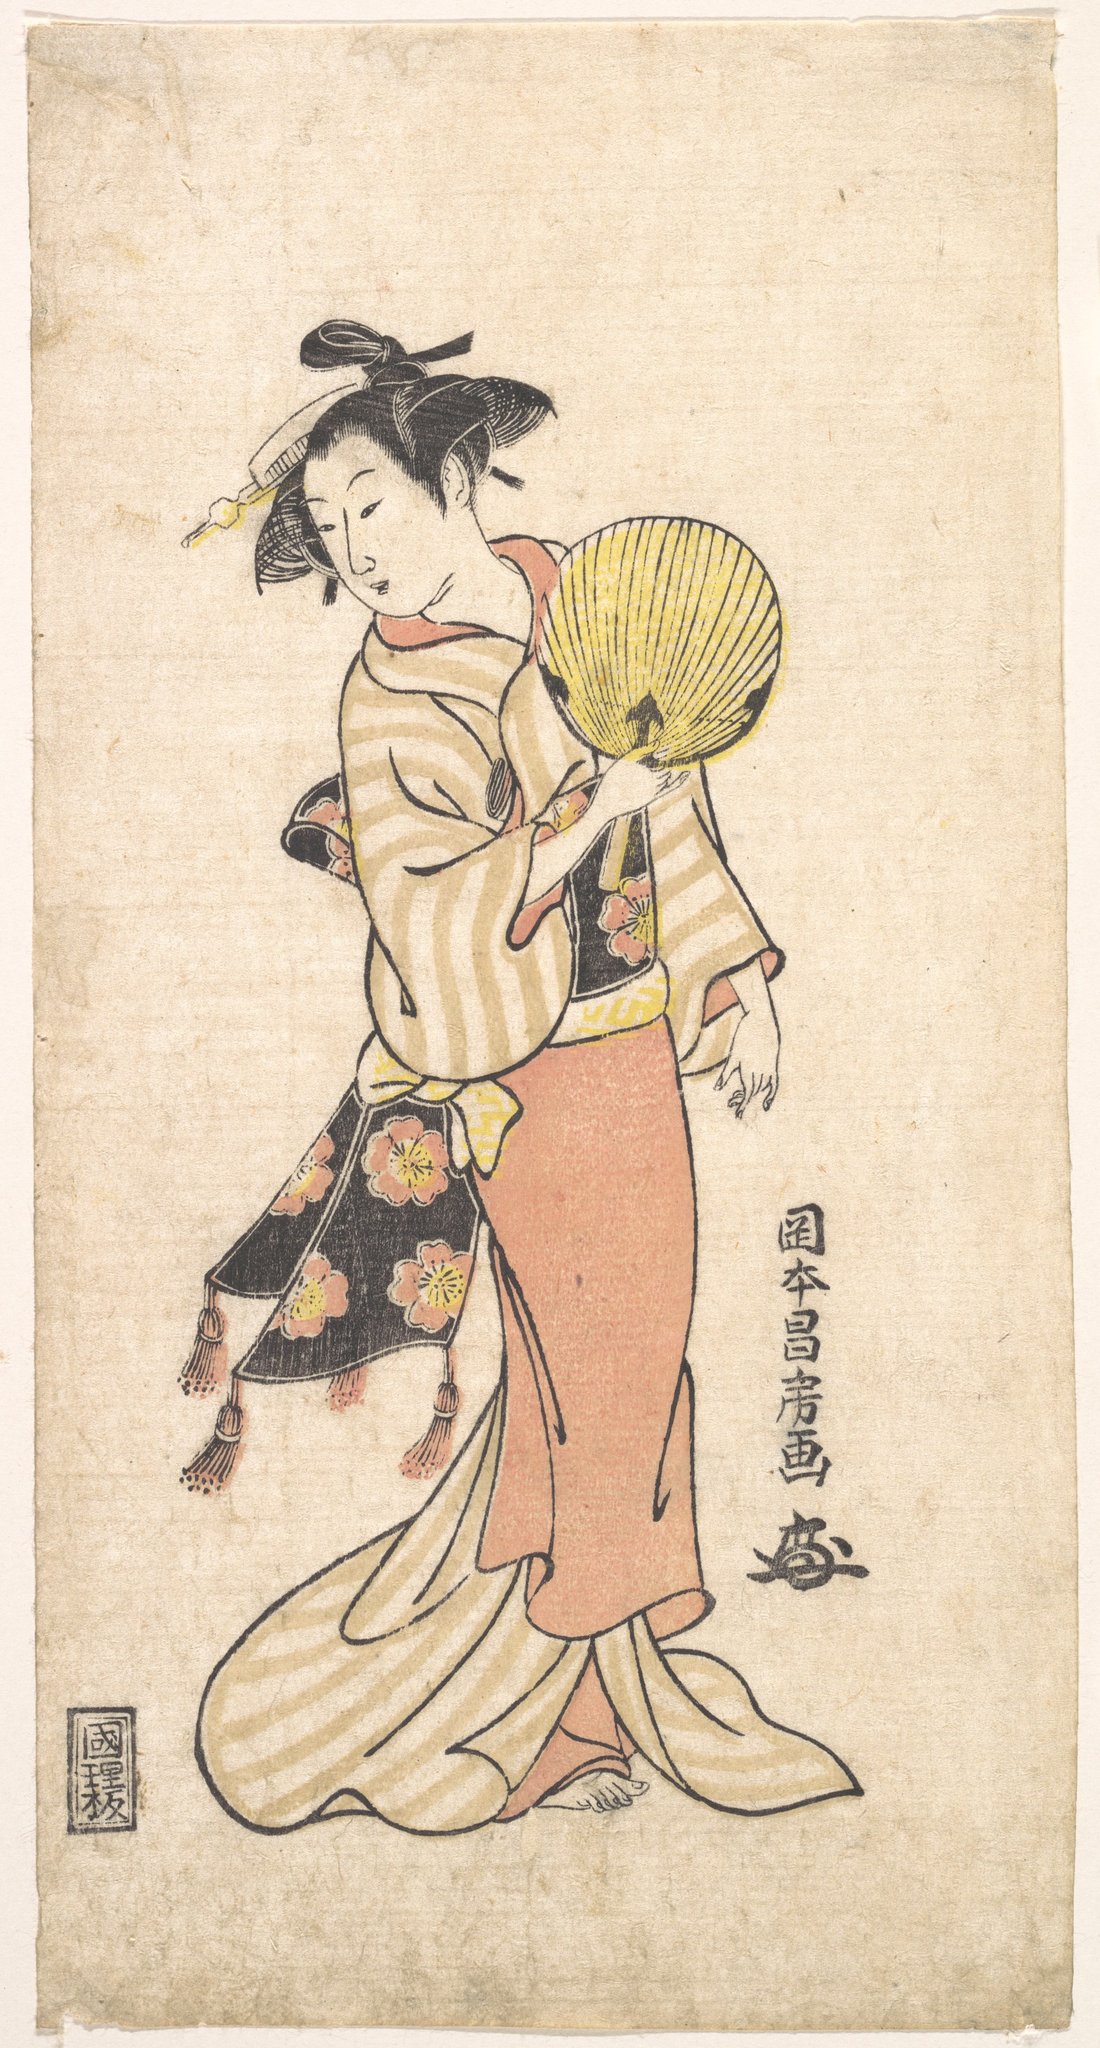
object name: print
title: Girl with Fan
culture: japanese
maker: masafusa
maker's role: artist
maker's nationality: japanese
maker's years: 1750-1770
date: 1750-1770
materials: ink, paper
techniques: woodblock print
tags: fans,women